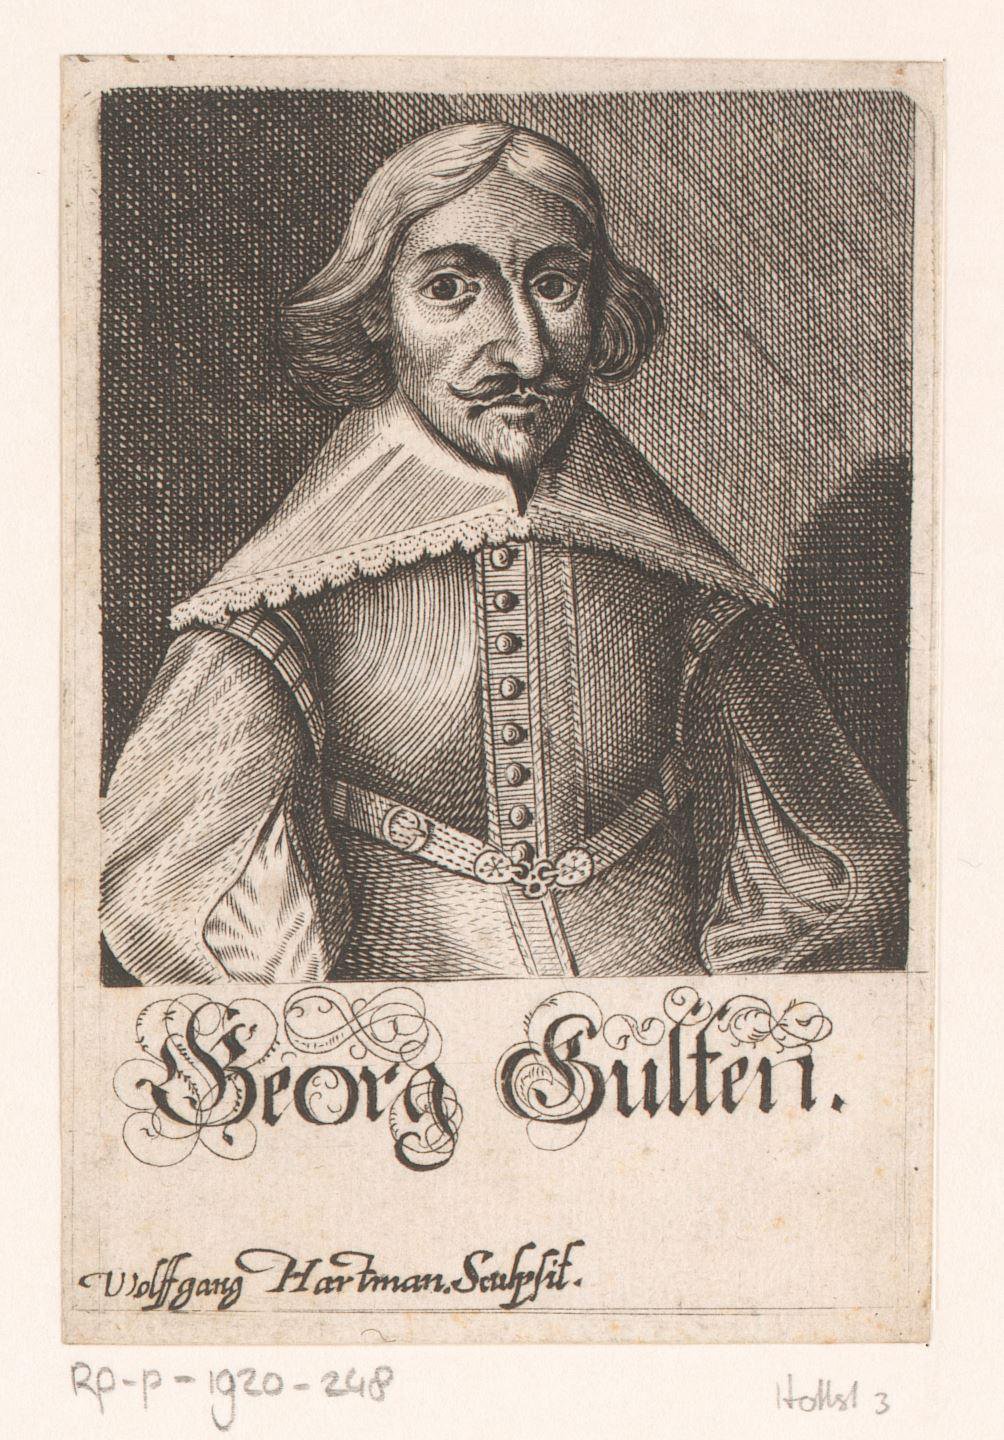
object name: print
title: Portret van Johann Quistorp op 64-jarige leeftijd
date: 1647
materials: paper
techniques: engraving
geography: rostock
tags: theologian, historical persons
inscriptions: collector's mark: Lugt 2228